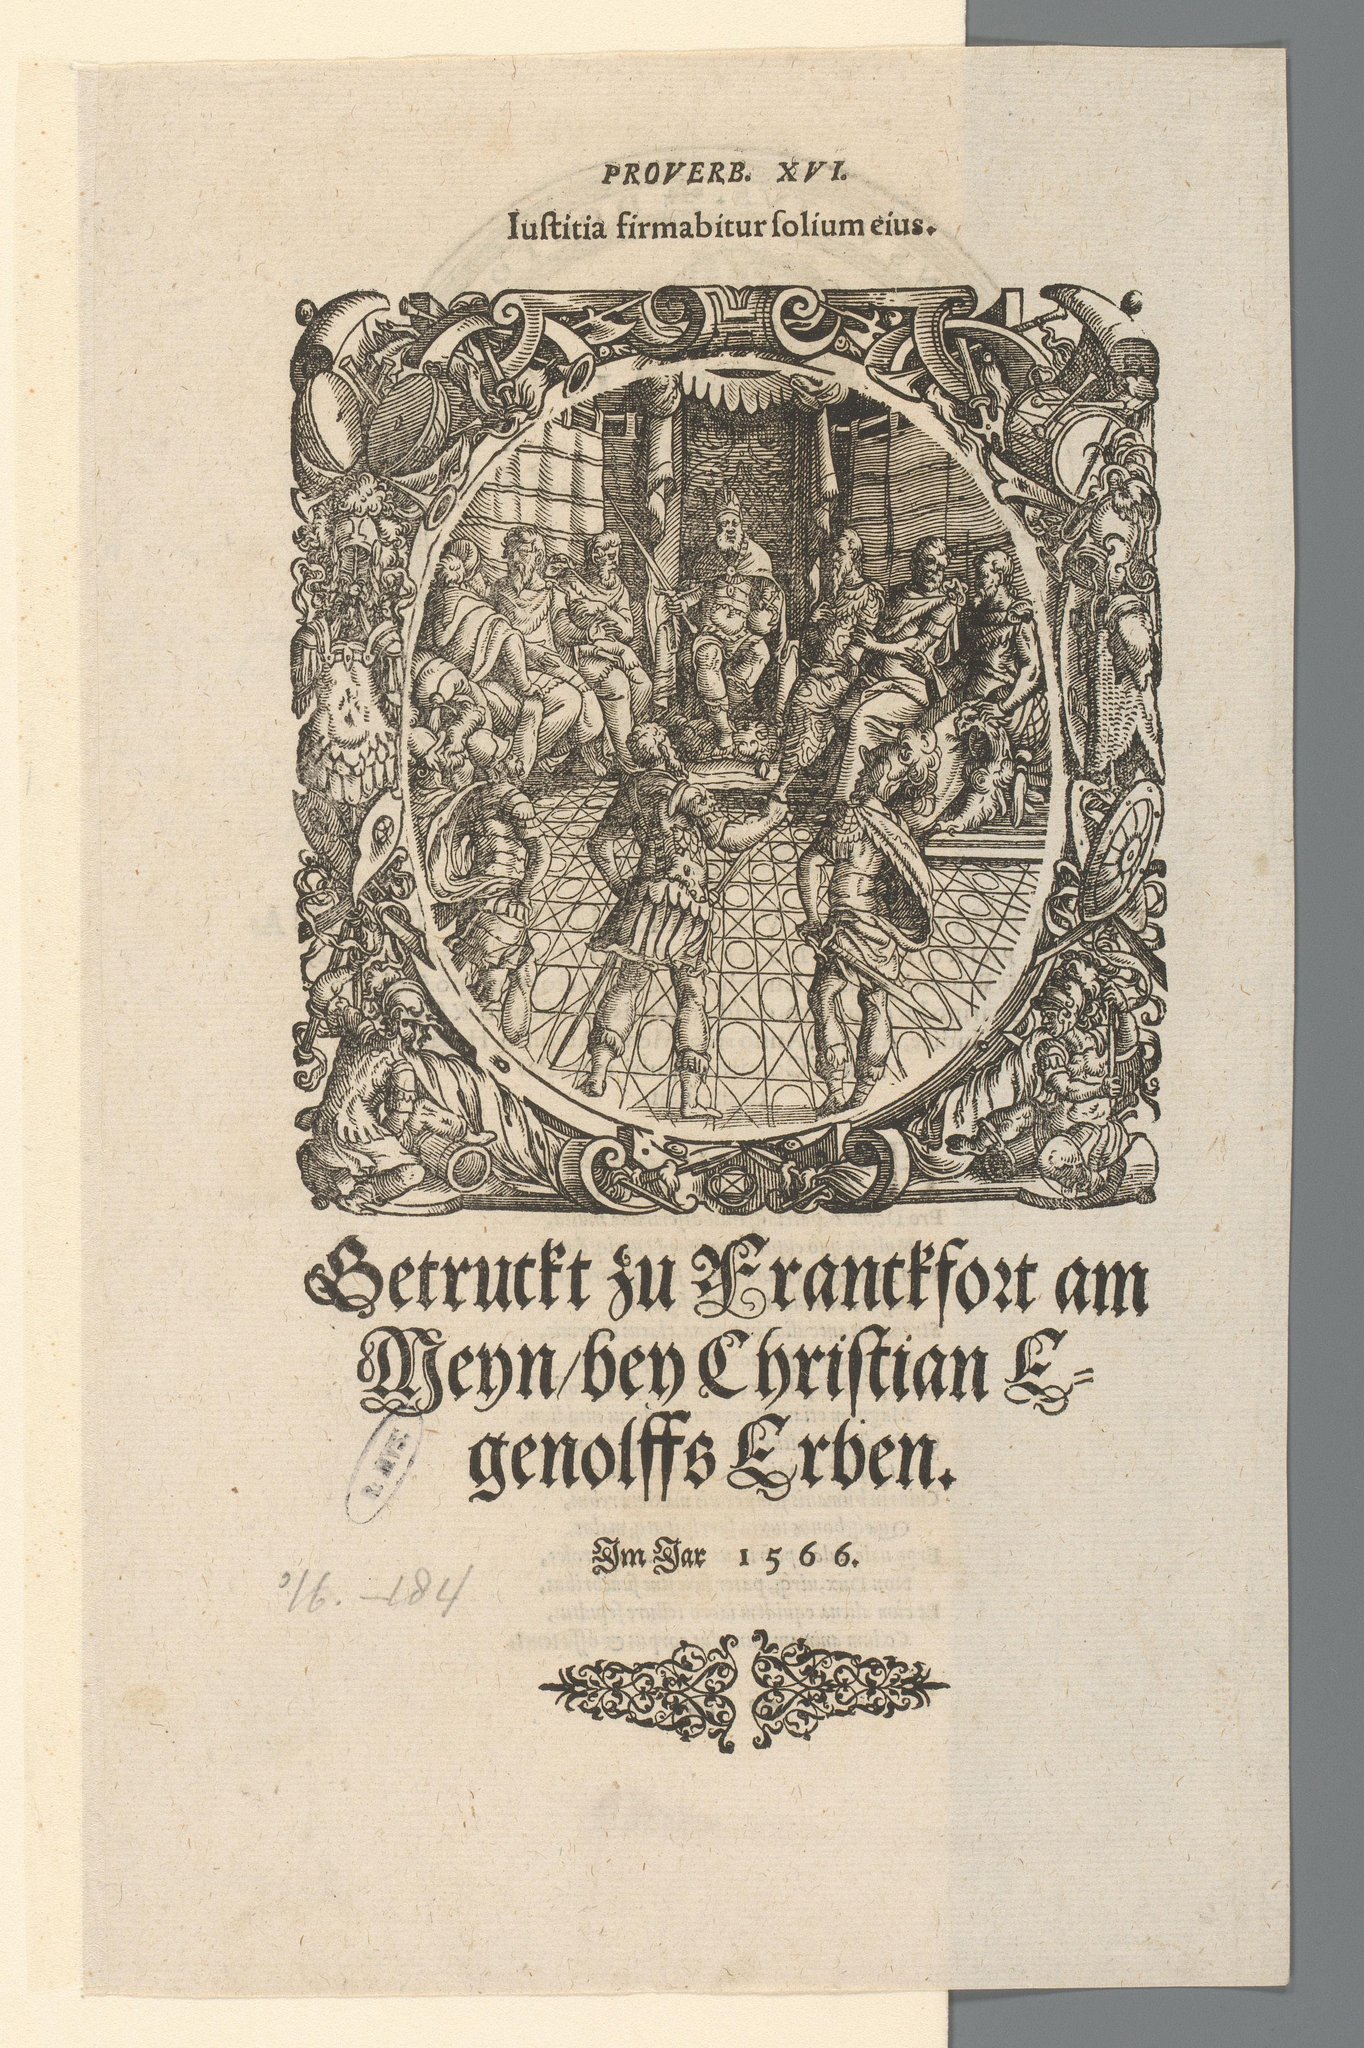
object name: book illustration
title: Heerser omringd door negen mannen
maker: jost amman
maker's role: draughtsman, painter, print maker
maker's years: 1539-1591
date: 1566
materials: paper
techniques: letterpress printing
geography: nuremberg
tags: ruler, sovereign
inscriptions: collector's mark: Lugt 2228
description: Prent mogelijk afkomstig uit de publicatie: Göbler, Justinus. Kriegßhändel. Frankfurt am Main: erven Christian Egenolff, 1566. In New Hollstein German wordt echter een andere ornamentrand beschreven.